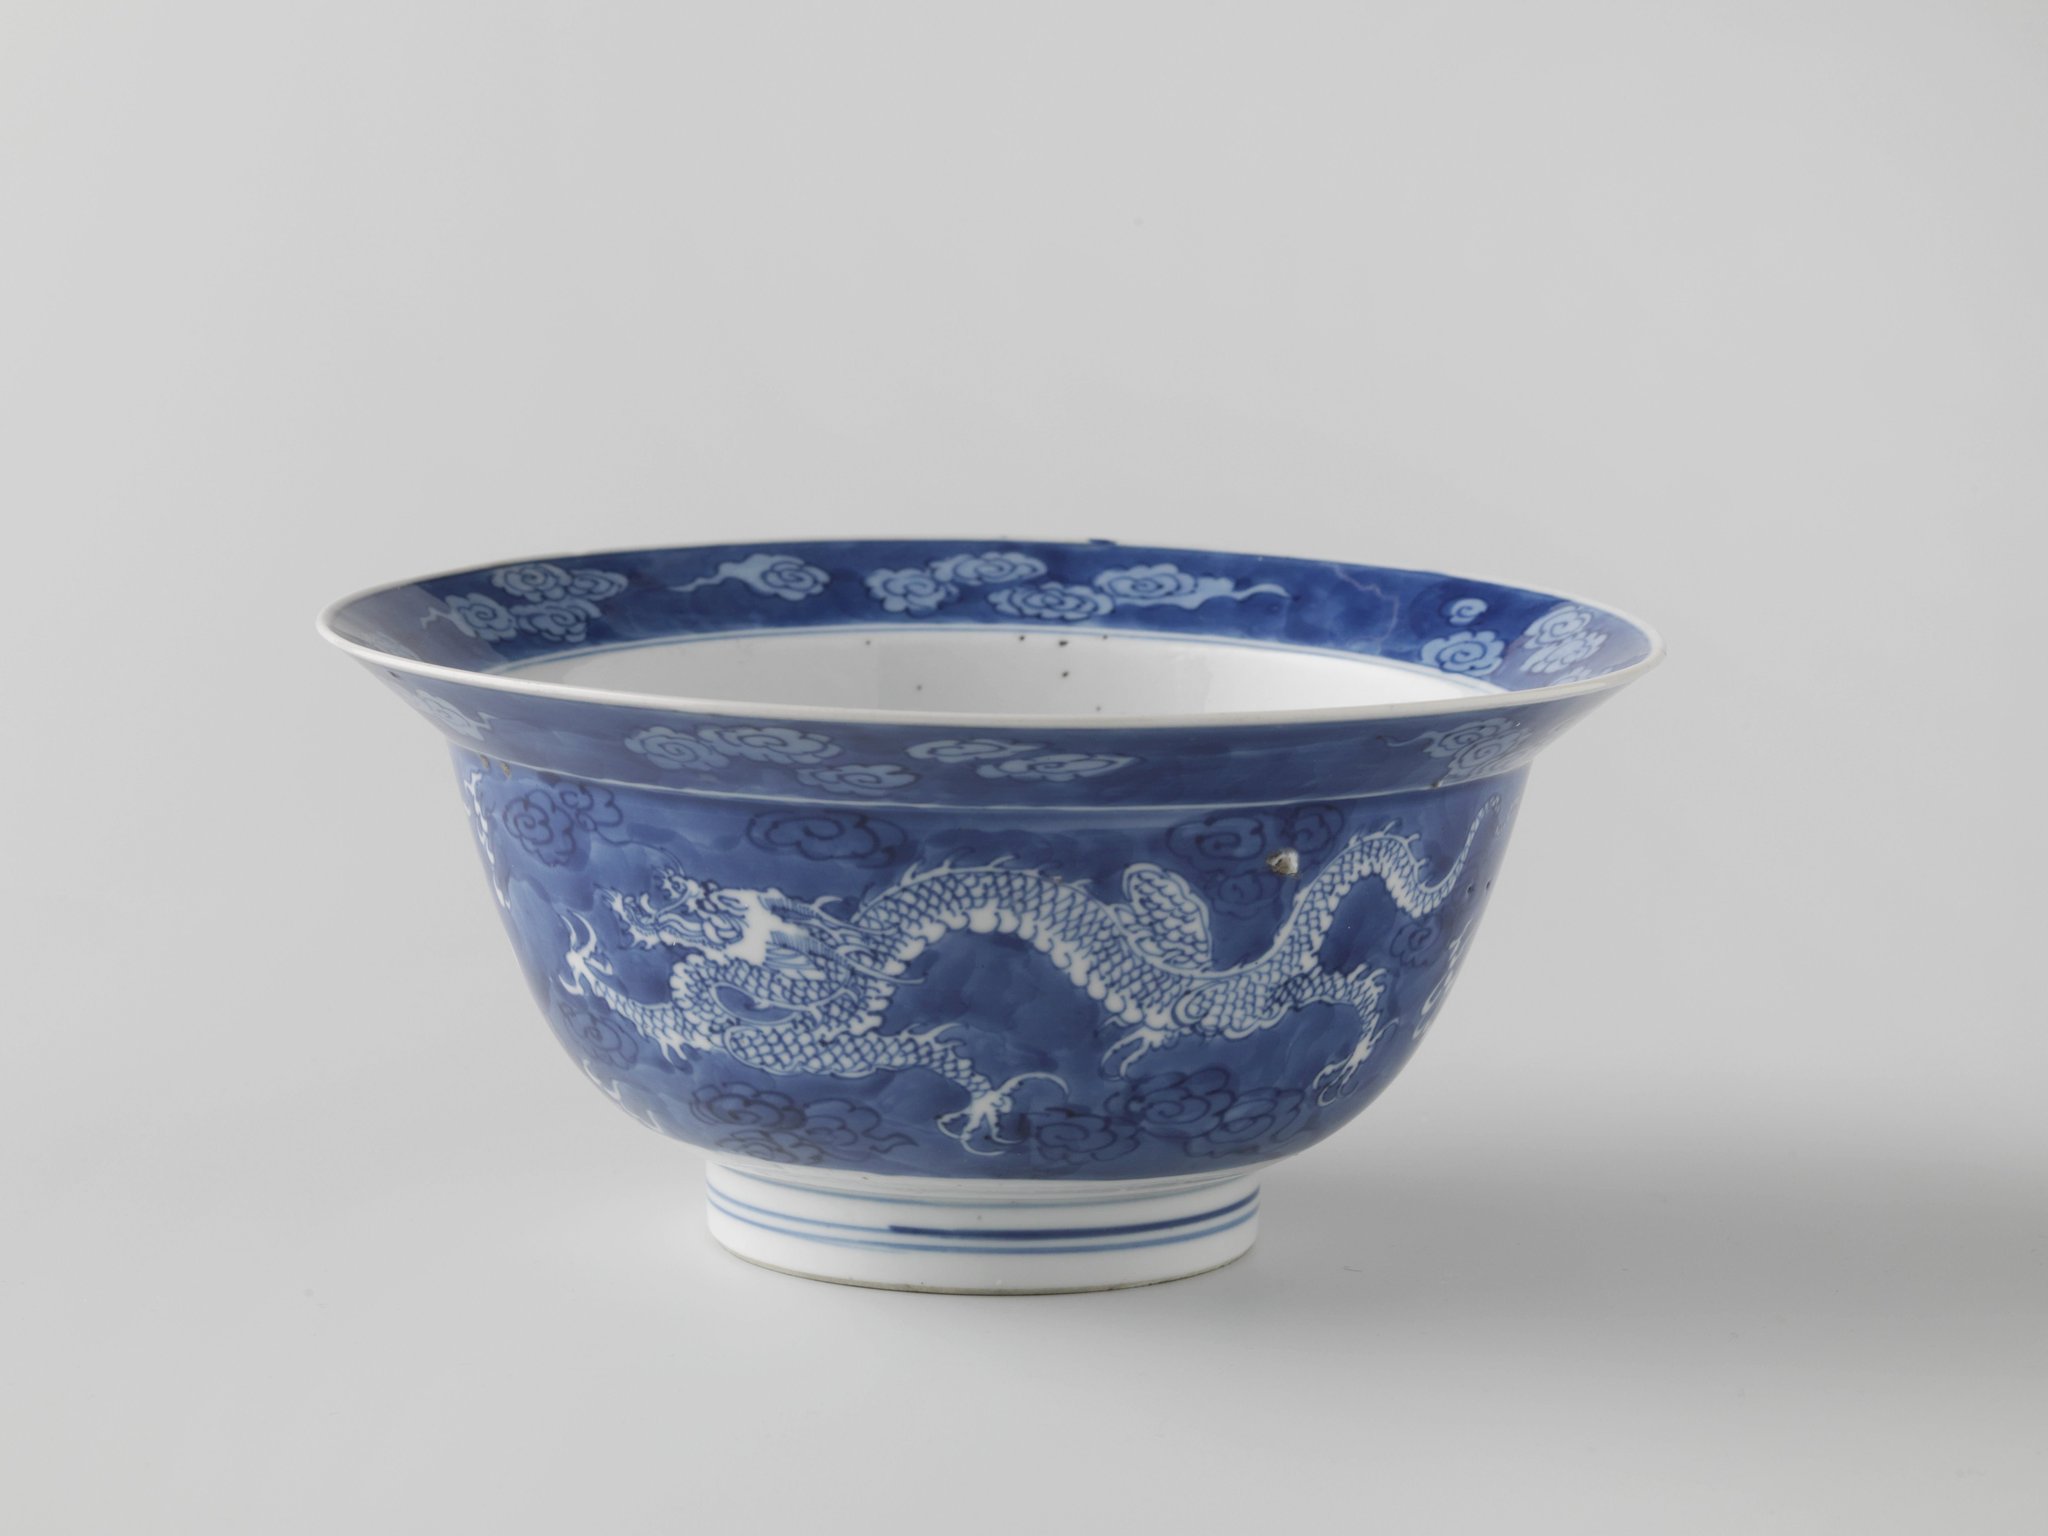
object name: bowl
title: Bowl with two pearl chasing dragons among clouds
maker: Anonymous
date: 1680-1720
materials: cobalt, glaze, paint, porcelain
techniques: firing, turning, vitrification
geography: china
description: Kom van porselein met spreidende rand, beschilderd in onderglazuur blauw. De buitenwand is bedekt met blauw met daarin uitgespaard tweemaal een parel najagende, vierklauwige draak tussen wolken. De binnen- en buitenrand zijn ook bedekt met blauw met daarin uitgespaard een wolkmotief. Op de bodem een rots omringd door kolkende golven met daarboven de maan tussen de wolken. Gemerkt op de onderzijde met het zes-karaktermerk van keizer Chenghua in een dubbele cirkel. Blauw-wit.